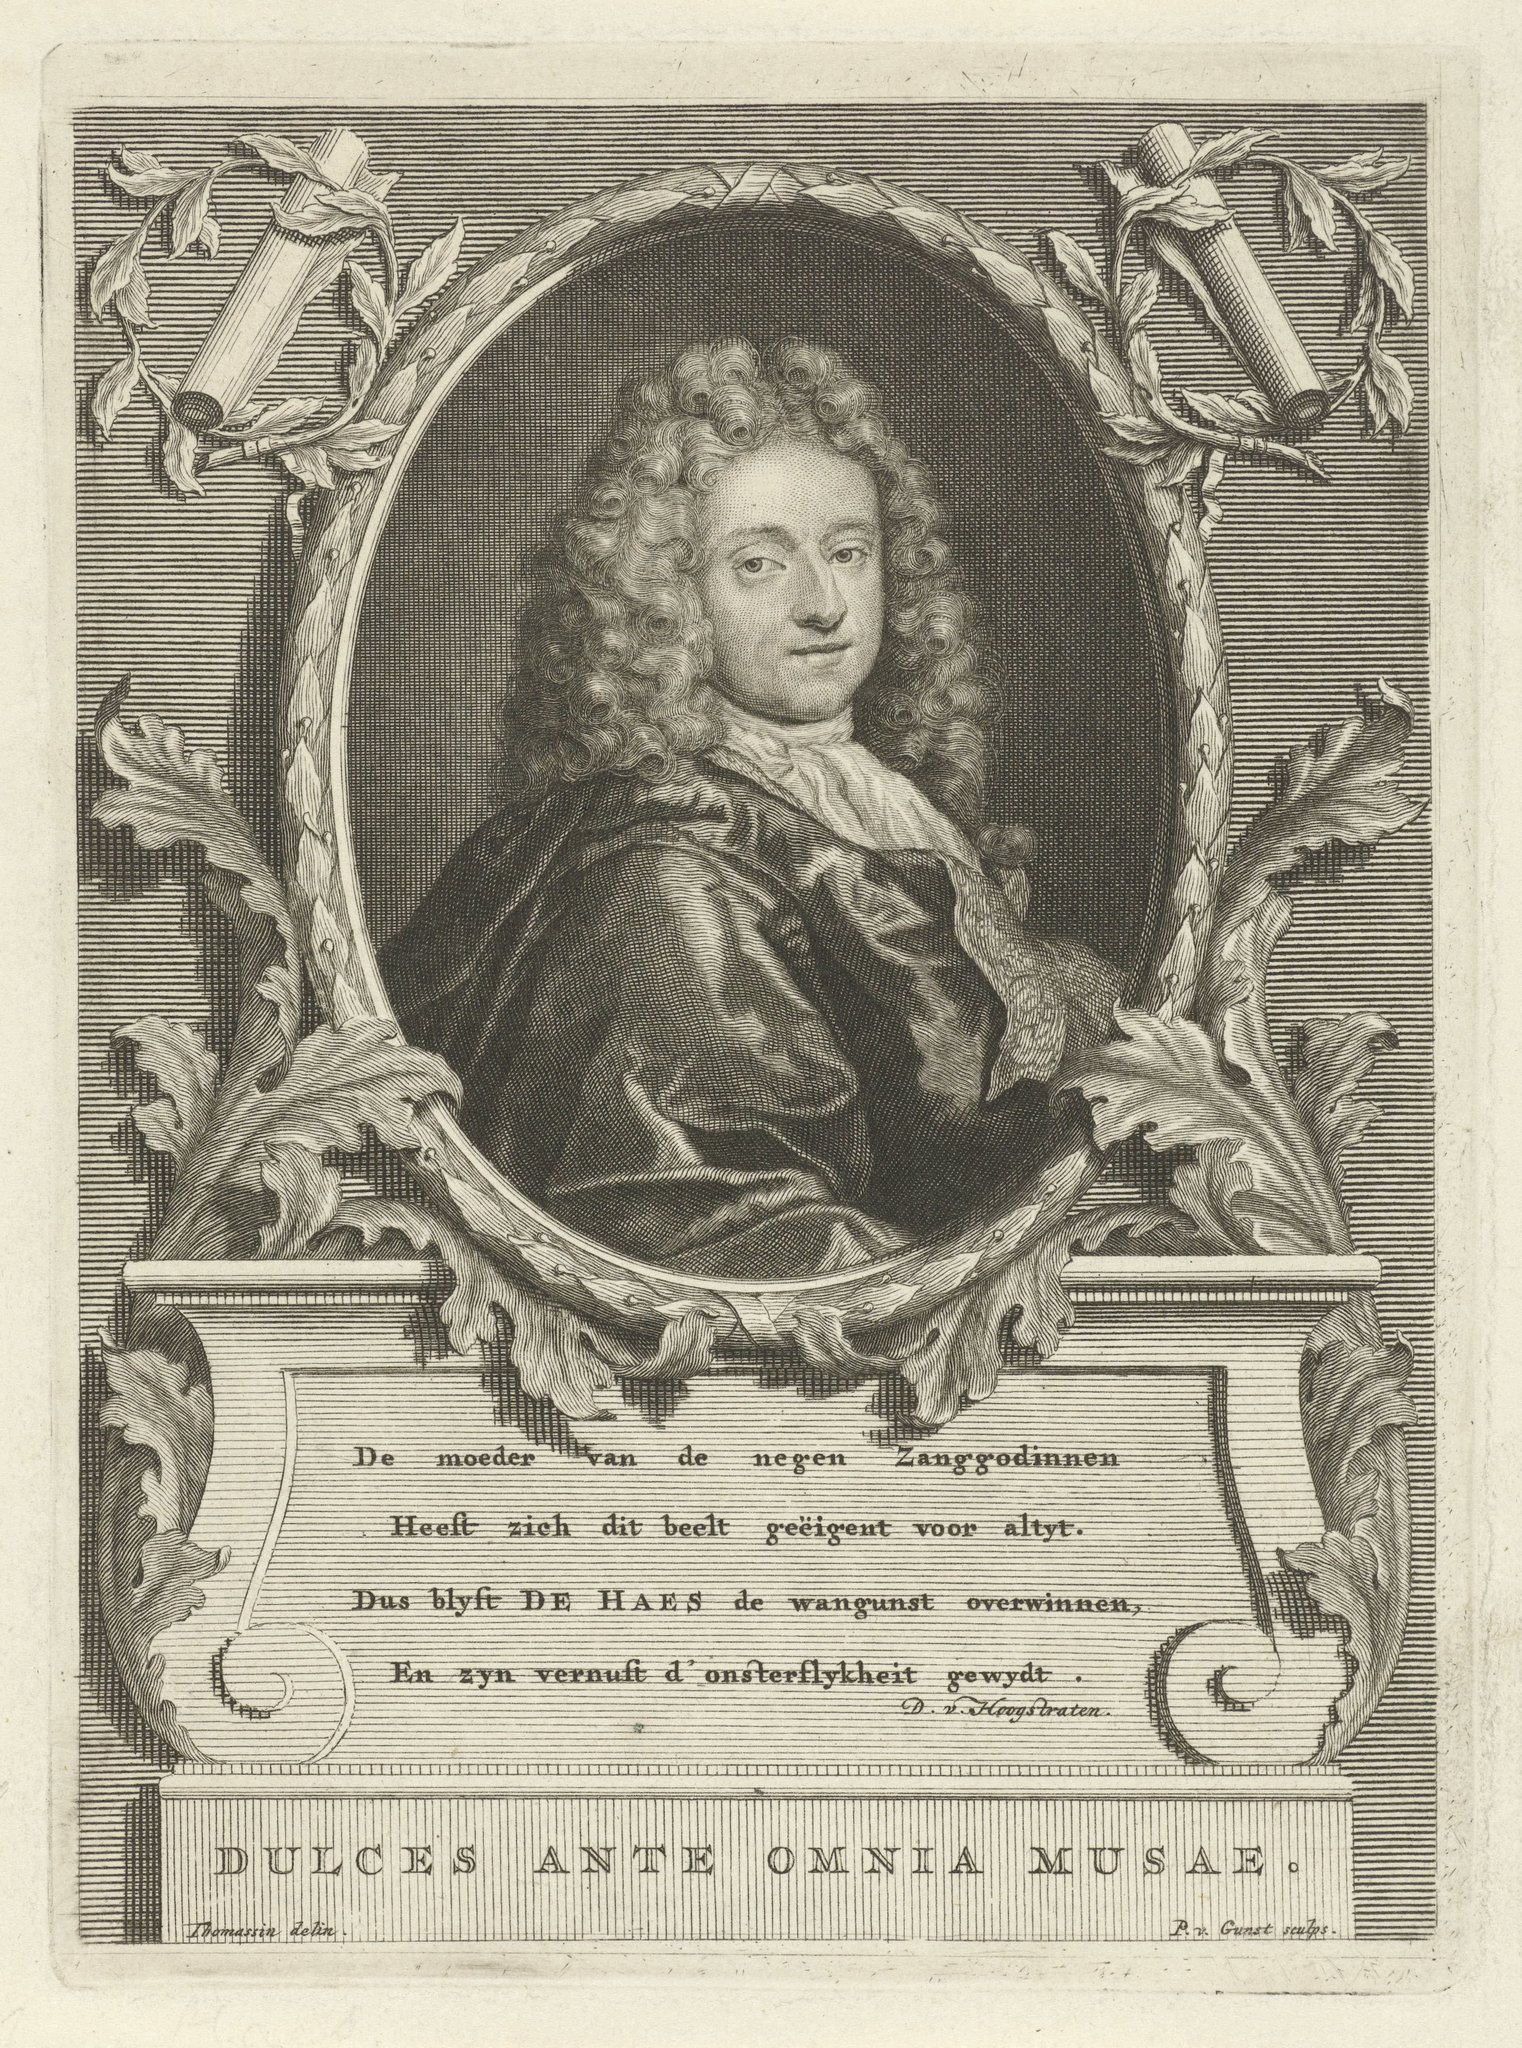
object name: print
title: Portret van Joan de Haes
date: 1723-1731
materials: paper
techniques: engraving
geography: amsterdam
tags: joan de haes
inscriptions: collector's mark: Lugt 2228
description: Joan de Haes, een Rotterdamse dichter. Onder het portret een Nederlands gedicht ter nagedachtenis van zijn leven.